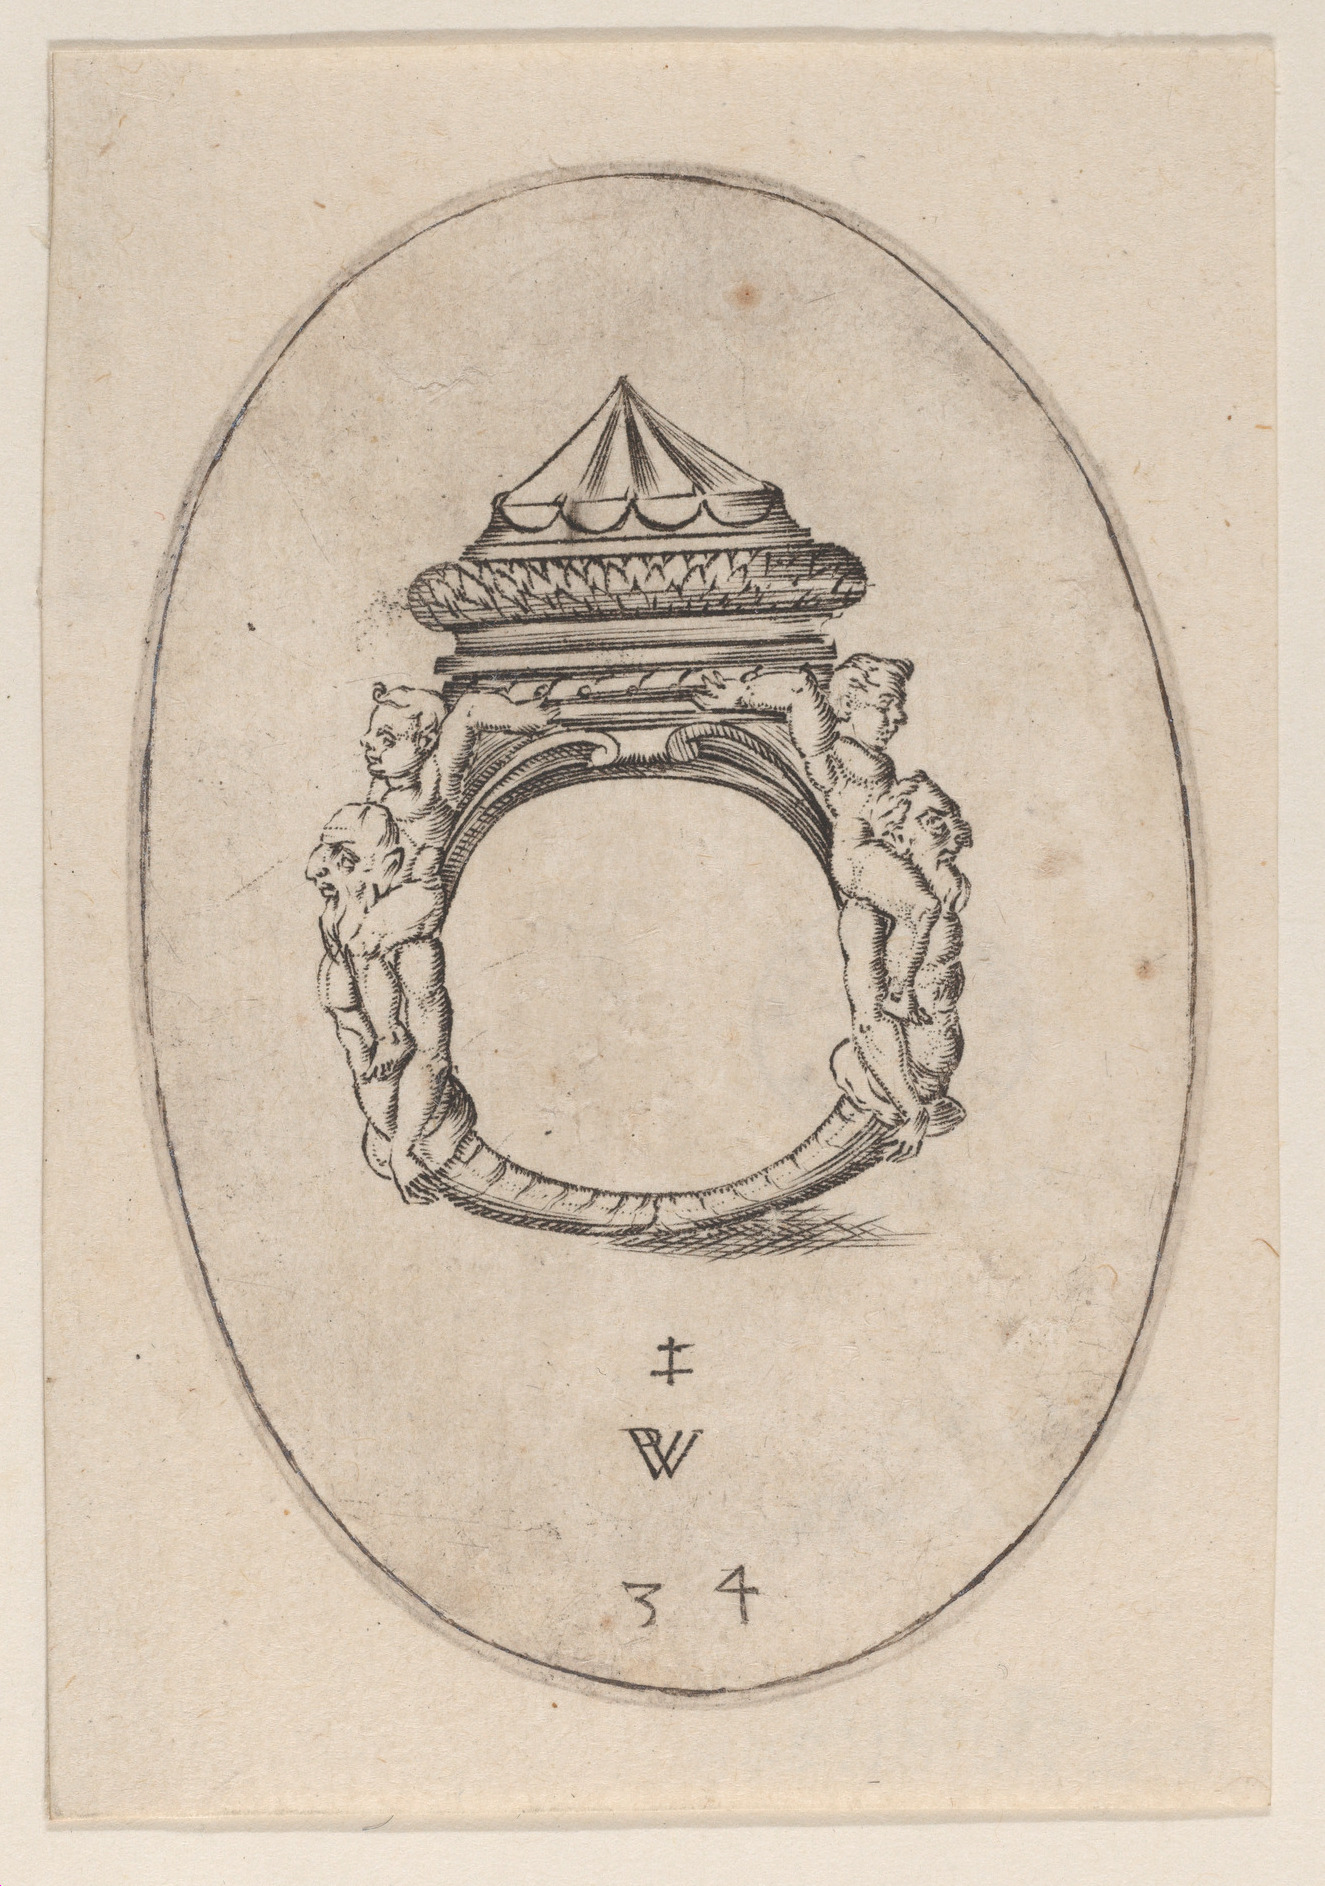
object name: print ornament architecture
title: Design for a Ring with a Large Faceted Gemstone, Plate 34 from 'Livre d'Aneaux d'Orfevrerie'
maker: pierre woeiriot de bouzey ii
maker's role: artist and engraver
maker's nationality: french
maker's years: 1532-1599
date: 1561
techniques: engraving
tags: rings